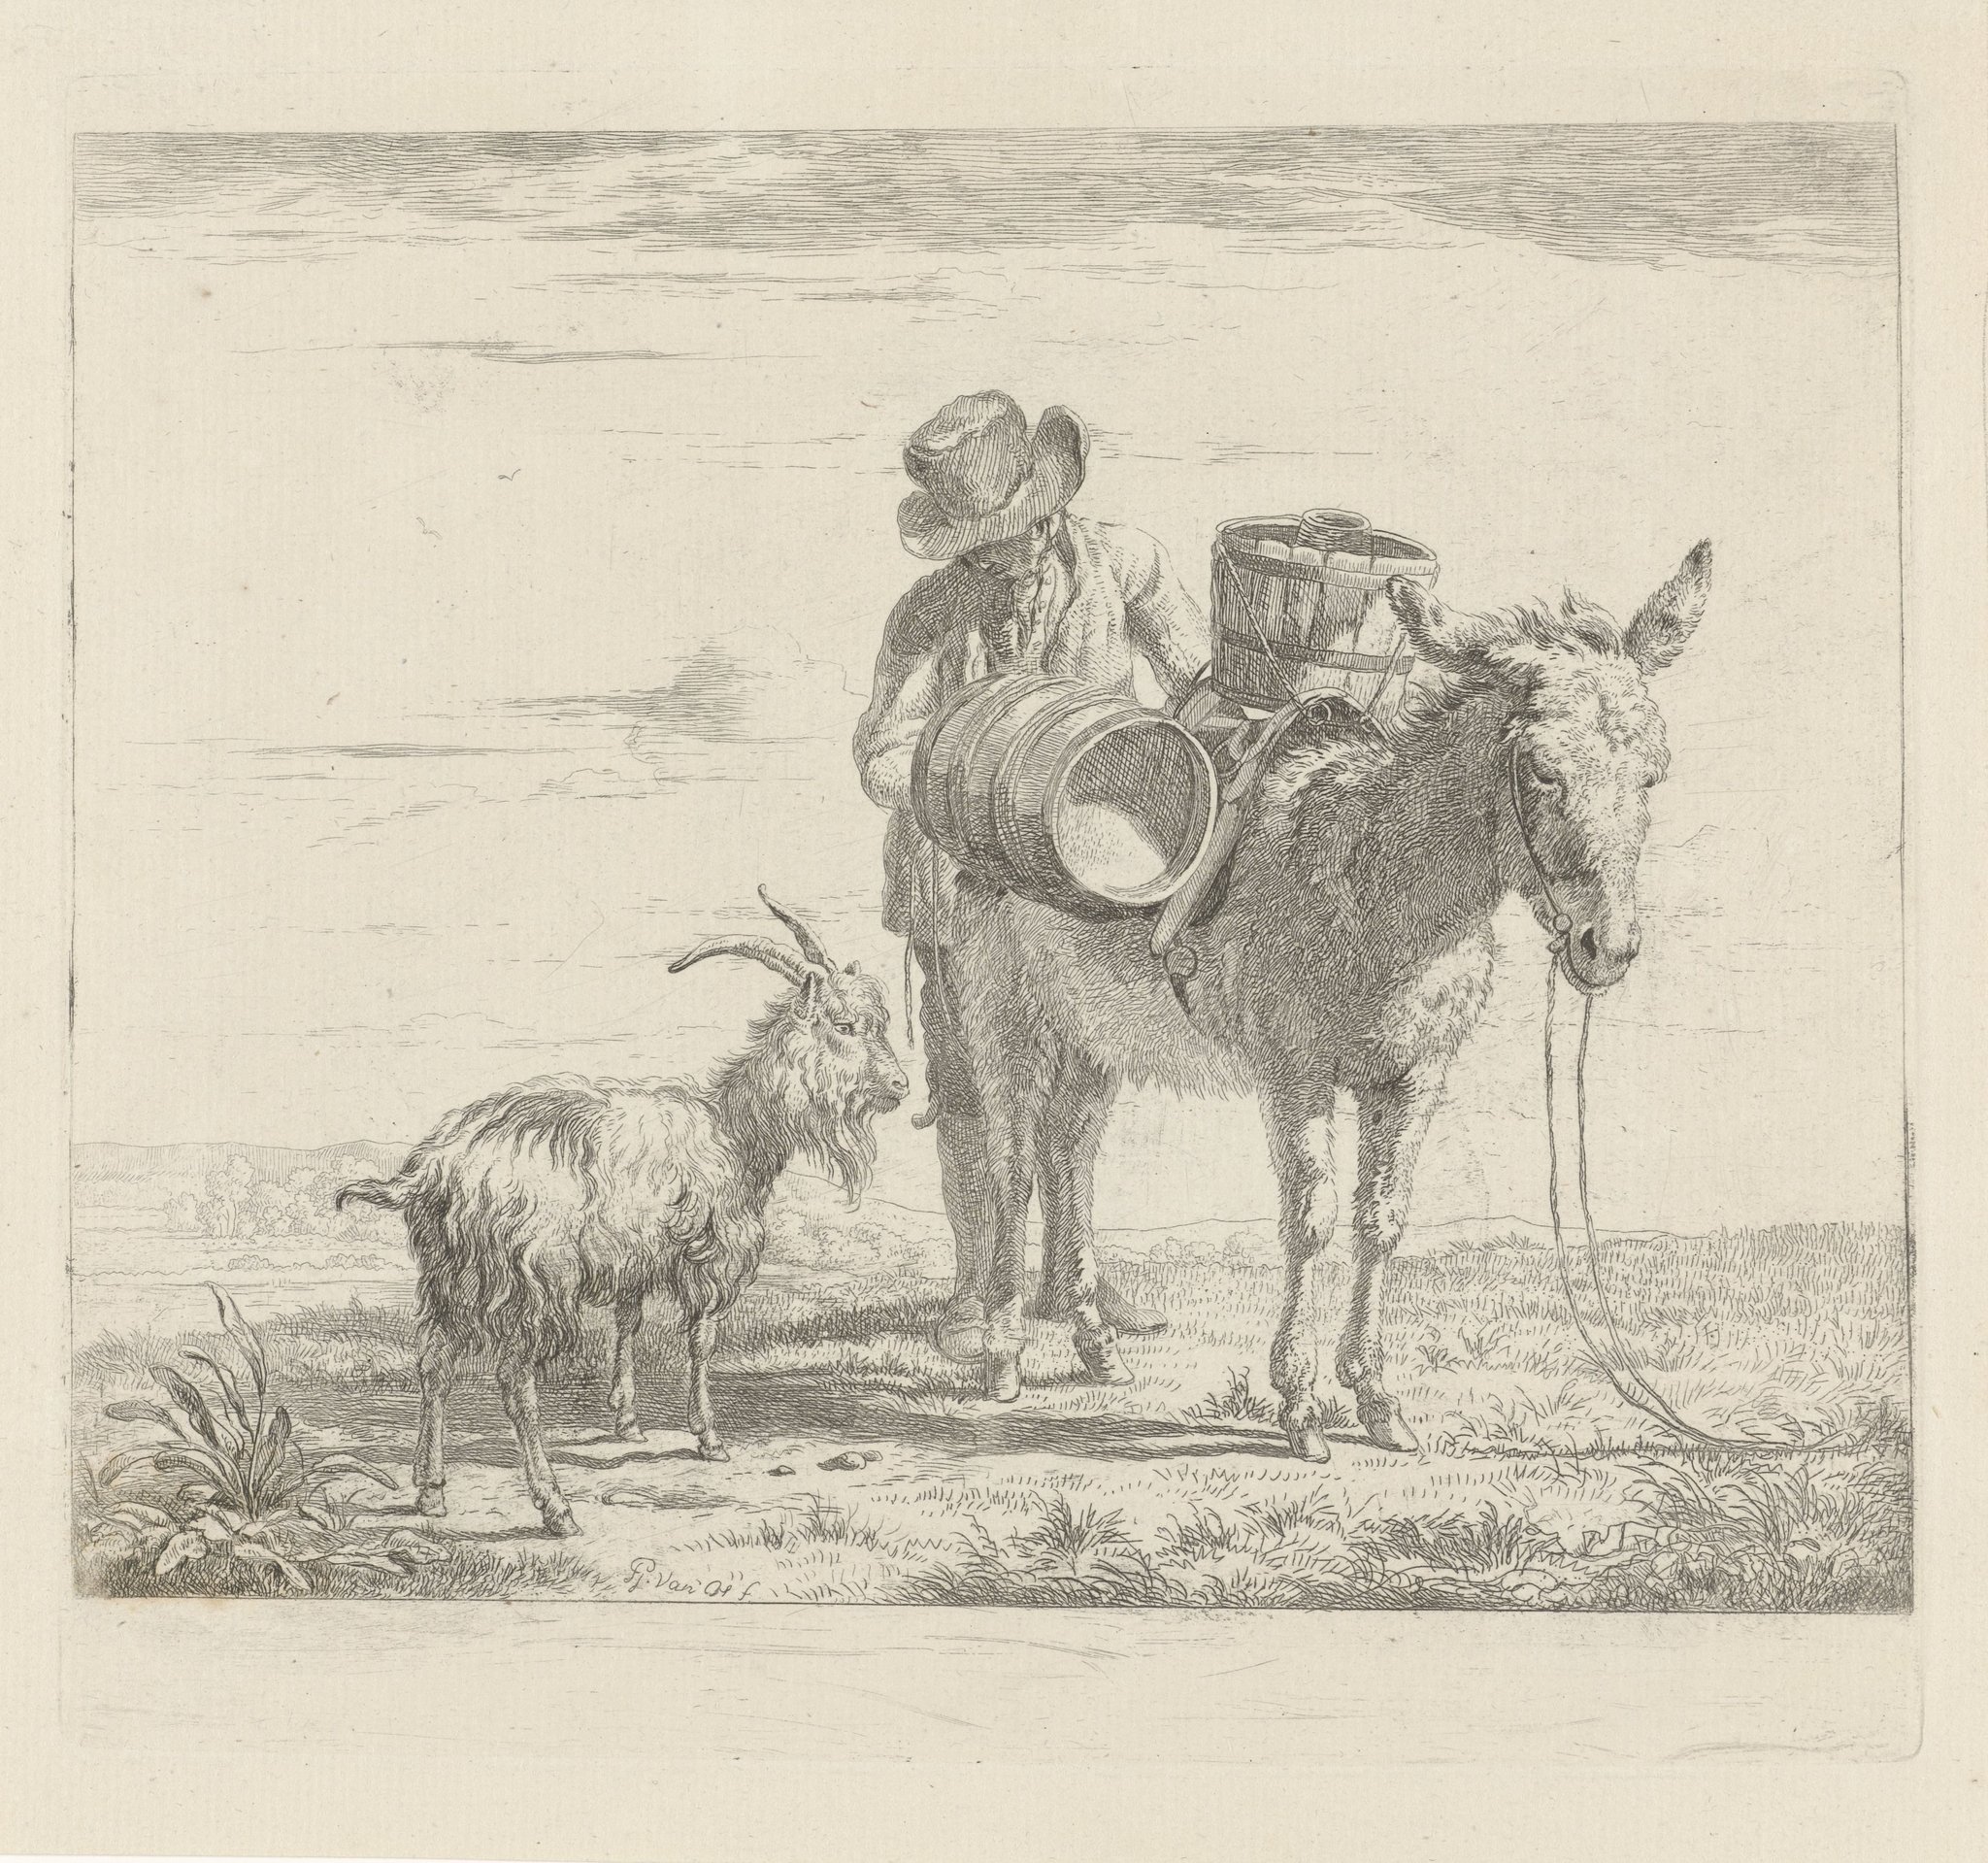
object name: print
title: Man met een pakezel en een geit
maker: pieter gerardus van os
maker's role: draughtsman, painter, print maker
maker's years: 1776-1839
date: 1791-1839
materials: paper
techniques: etching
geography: netherlands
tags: ass, donkey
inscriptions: collector's mark: Lugt 2228